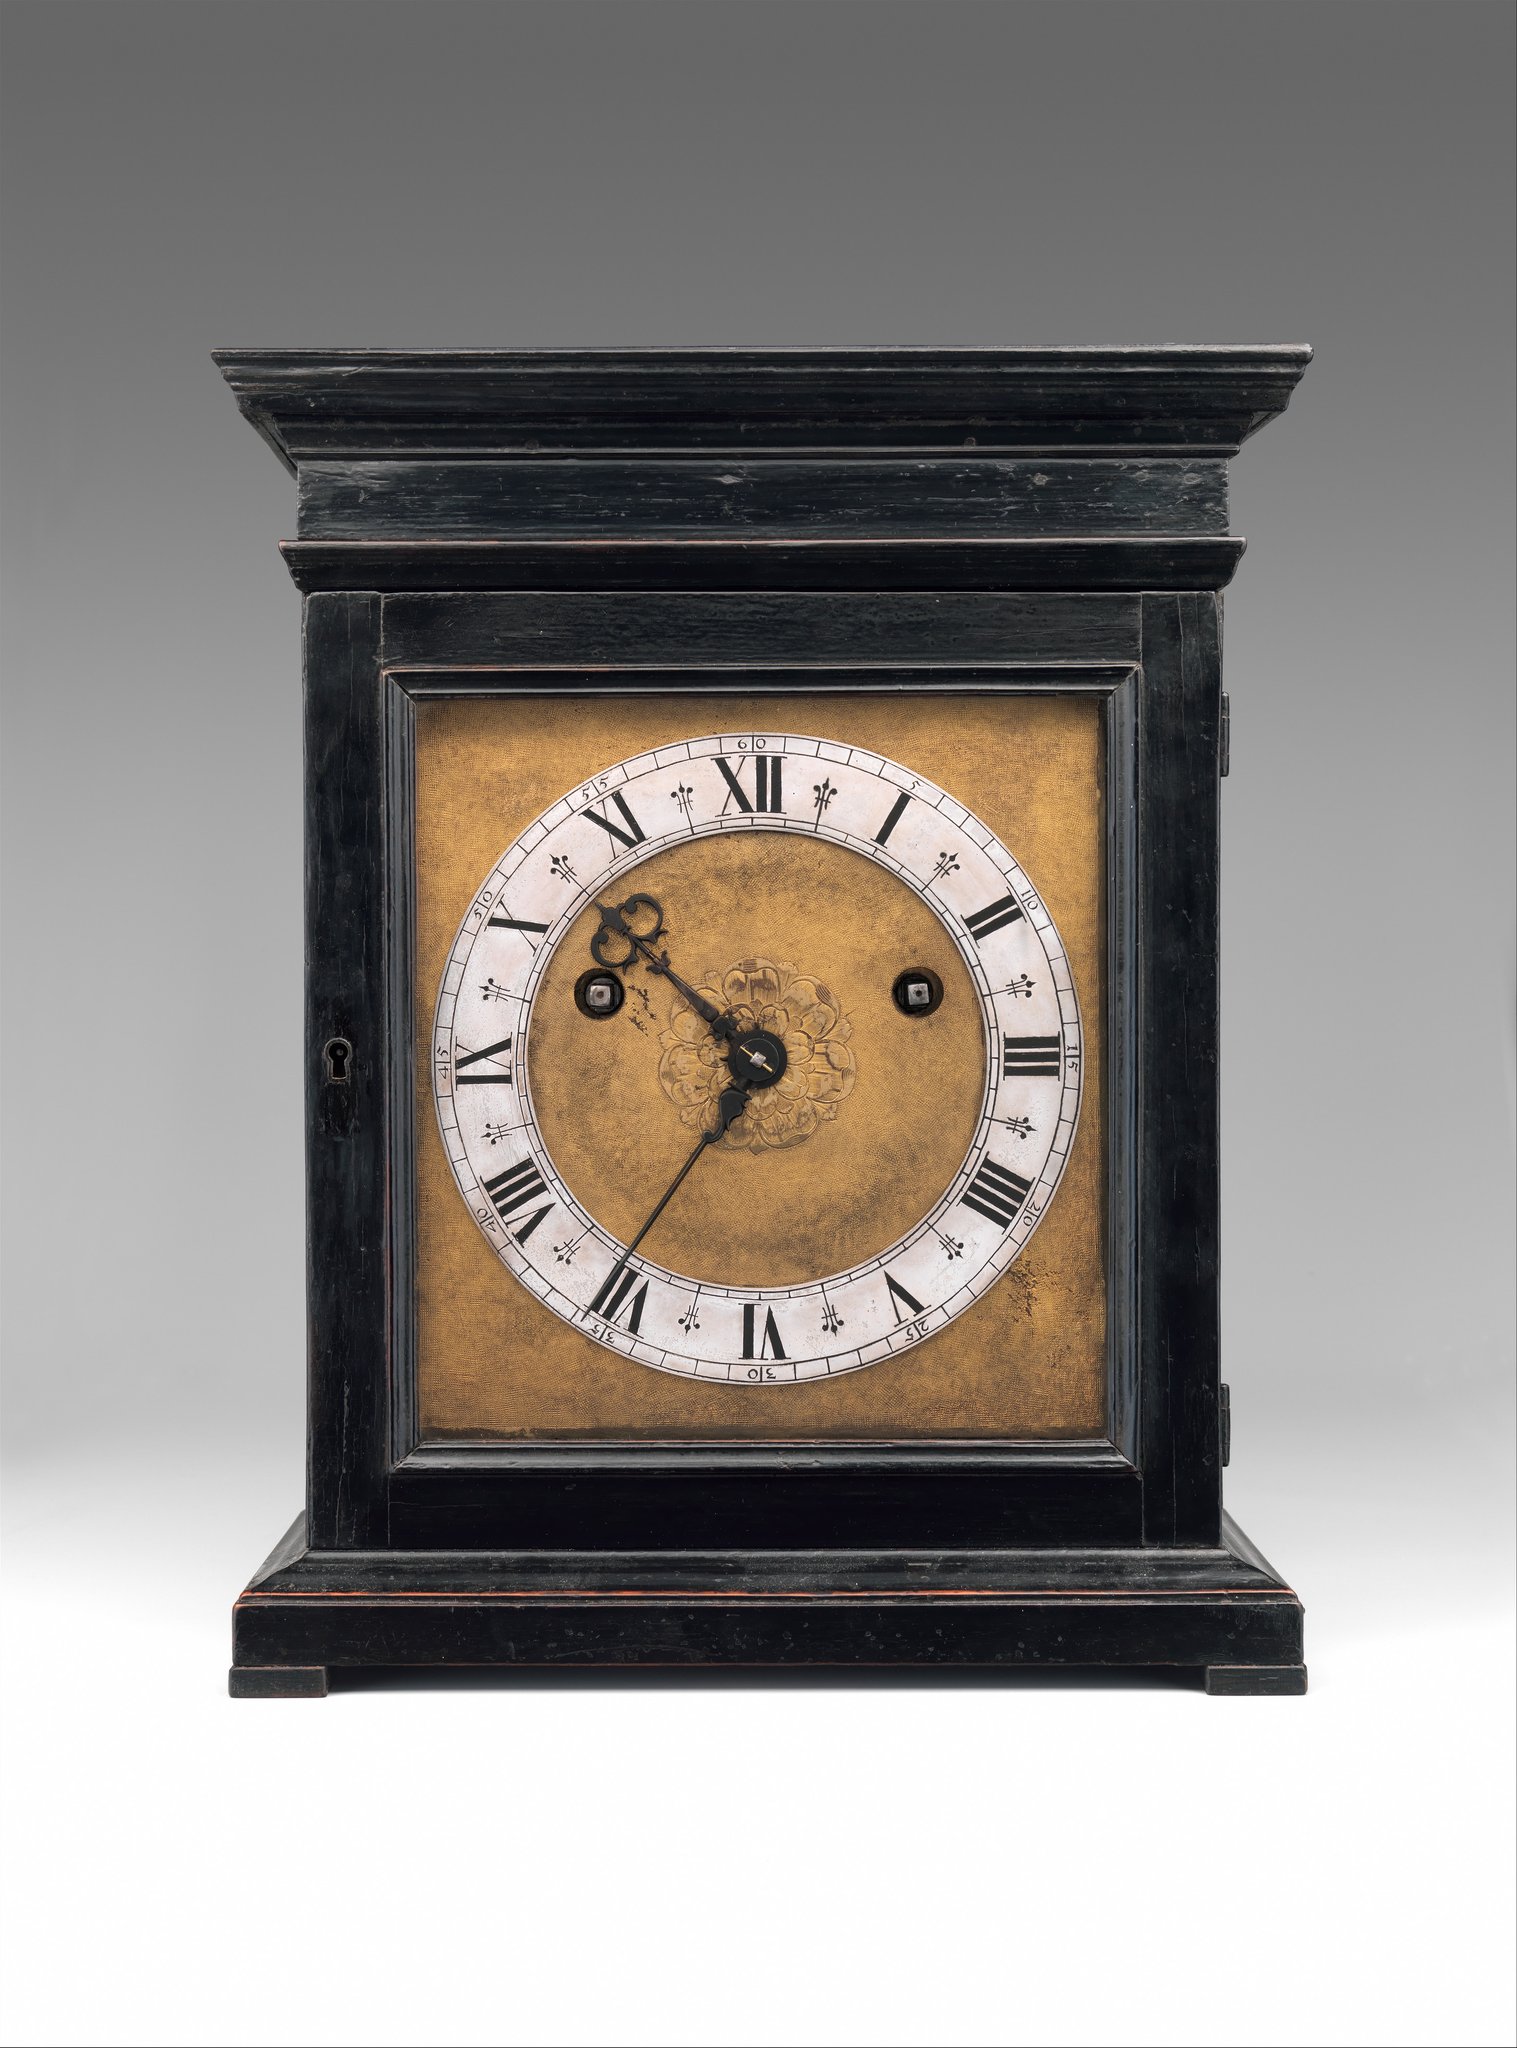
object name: table or bracket clock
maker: edward east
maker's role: maker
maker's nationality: british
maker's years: 1602-1697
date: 1665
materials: brass, wood, gilt brass, silver, steel